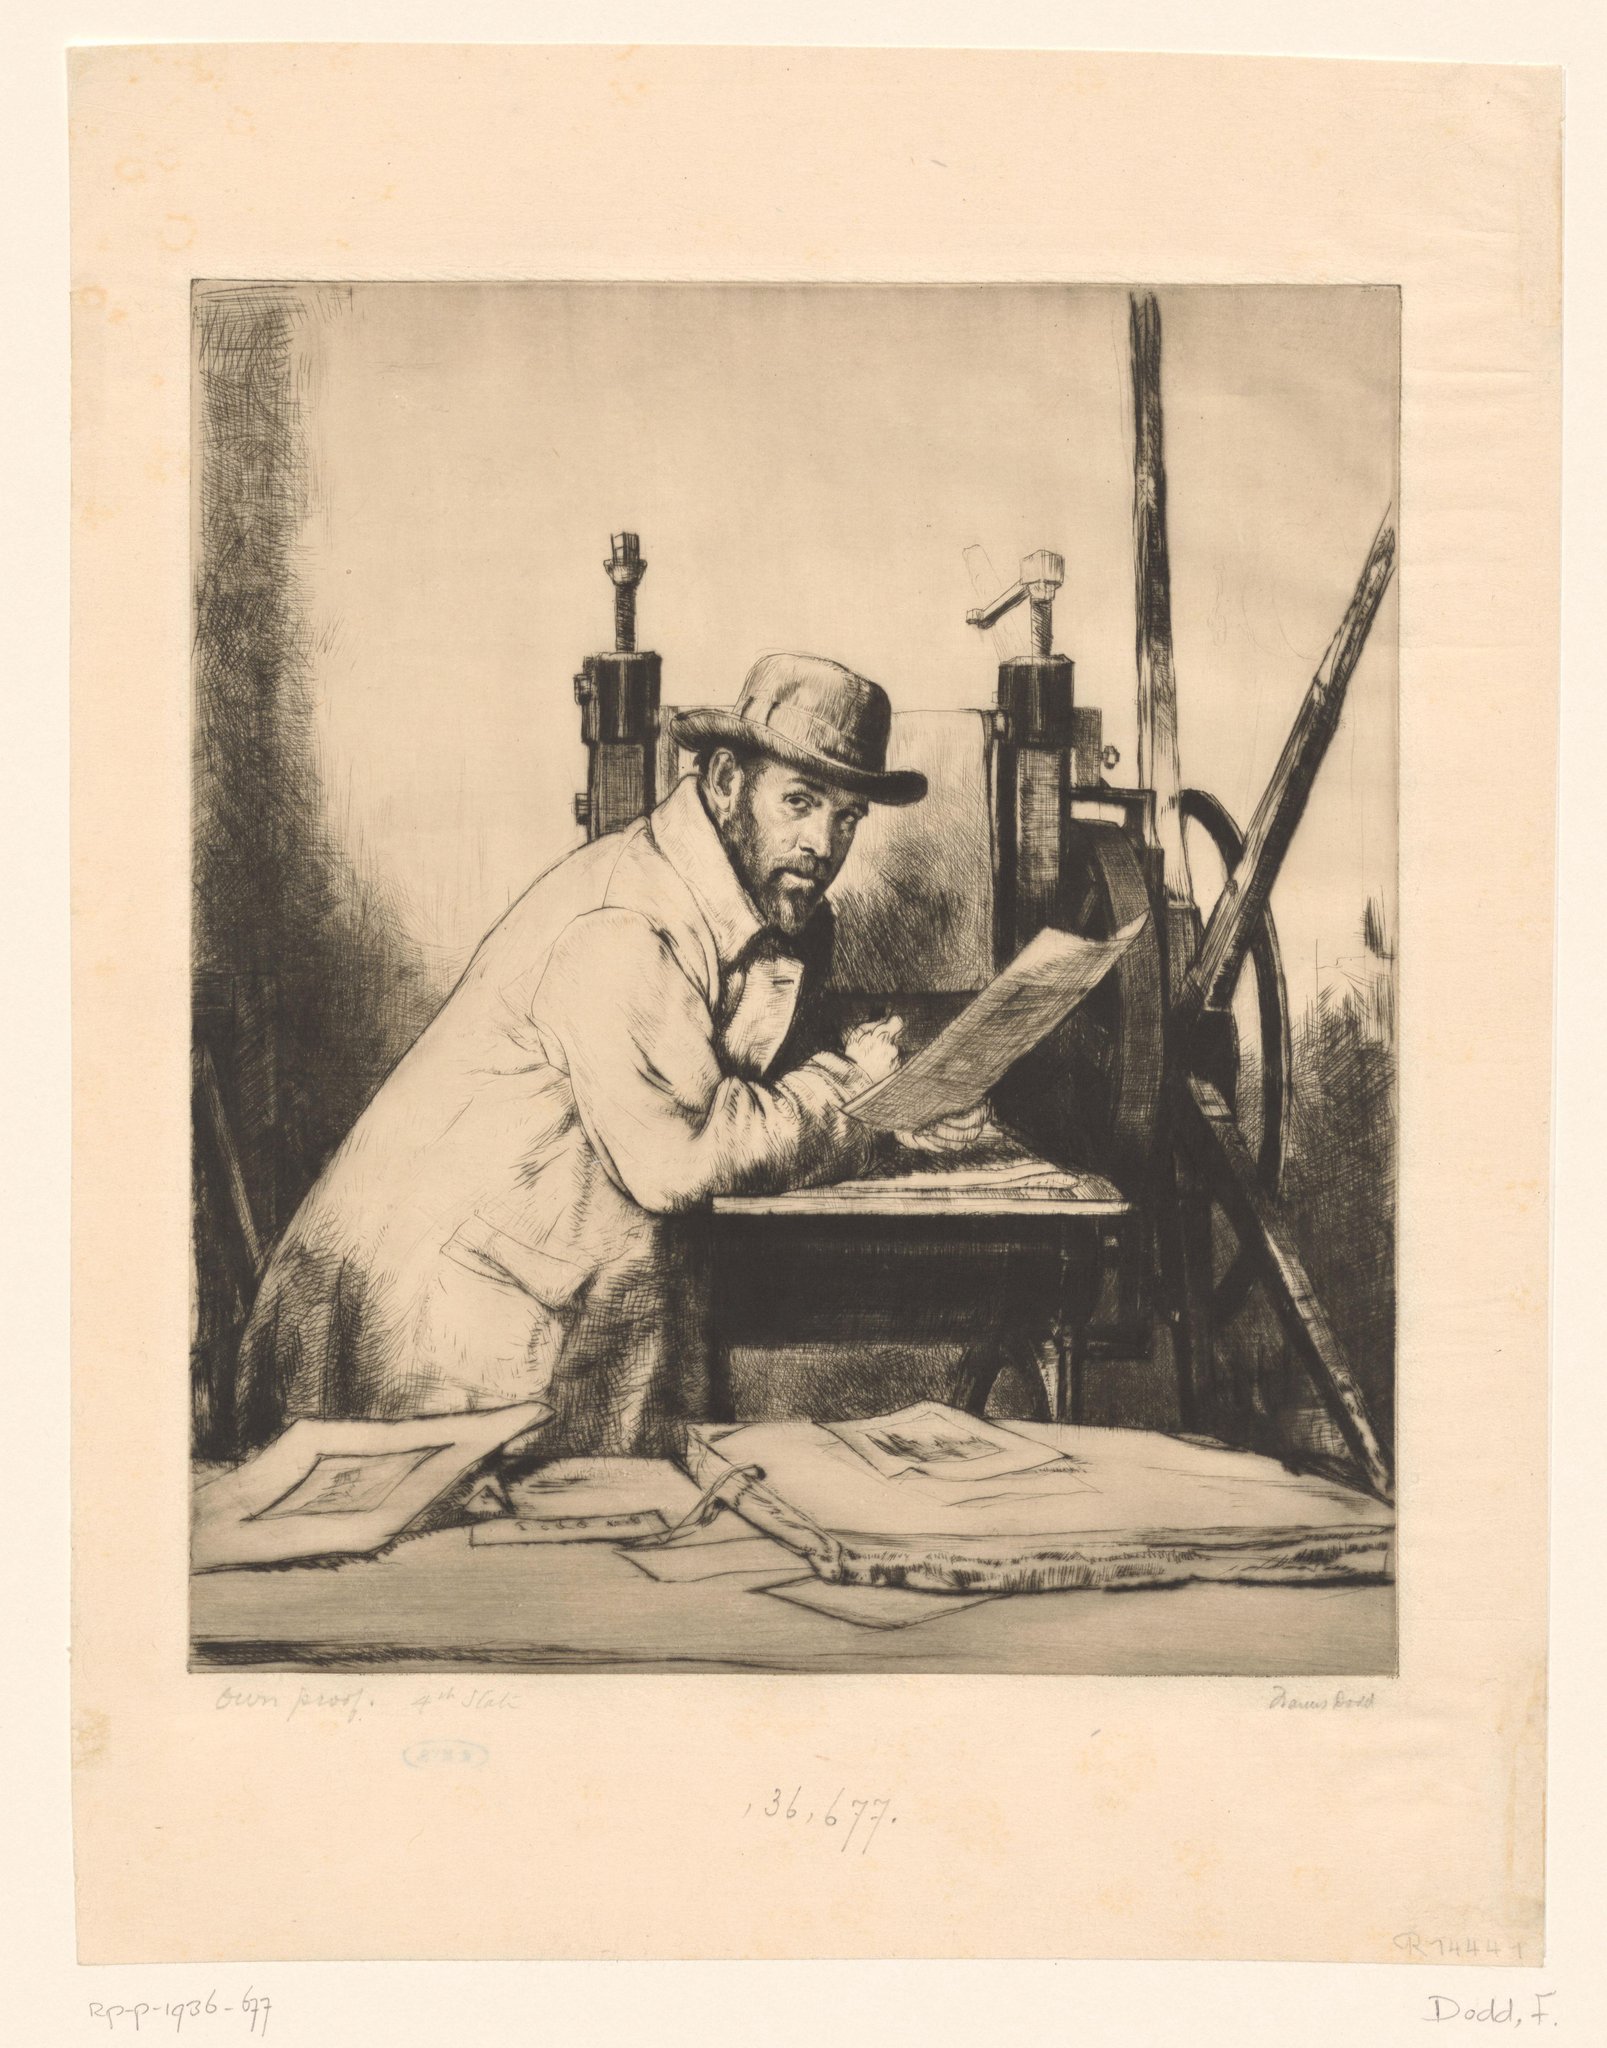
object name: print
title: Portret van Muirhead Bone leunend op zijn etspers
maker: francis dodd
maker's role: print maker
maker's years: 1874-1949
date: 1908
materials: paper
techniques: drypoint, etching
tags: print maker, artist, muirhead bone, print, e.g.: engraving, etching, lithograph, historical persons, printing press, graphic artist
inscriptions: inscription: ‘own proof. 4th state’, collector's mark: Lugt 2228